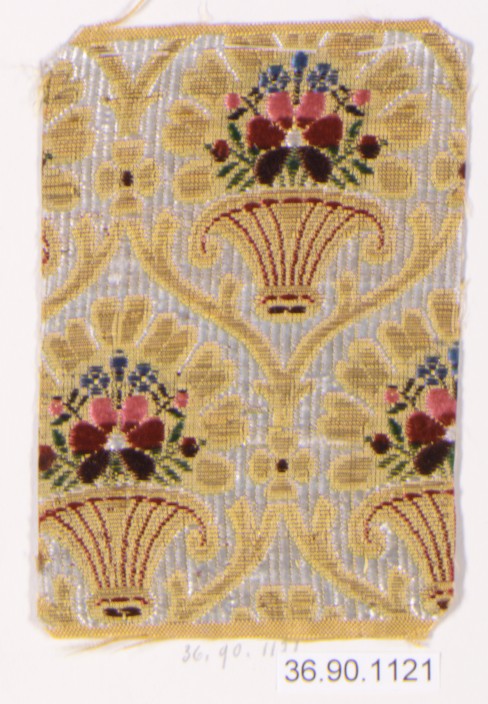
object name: sample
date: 1701-1900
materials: metal thread, silk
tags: flowers